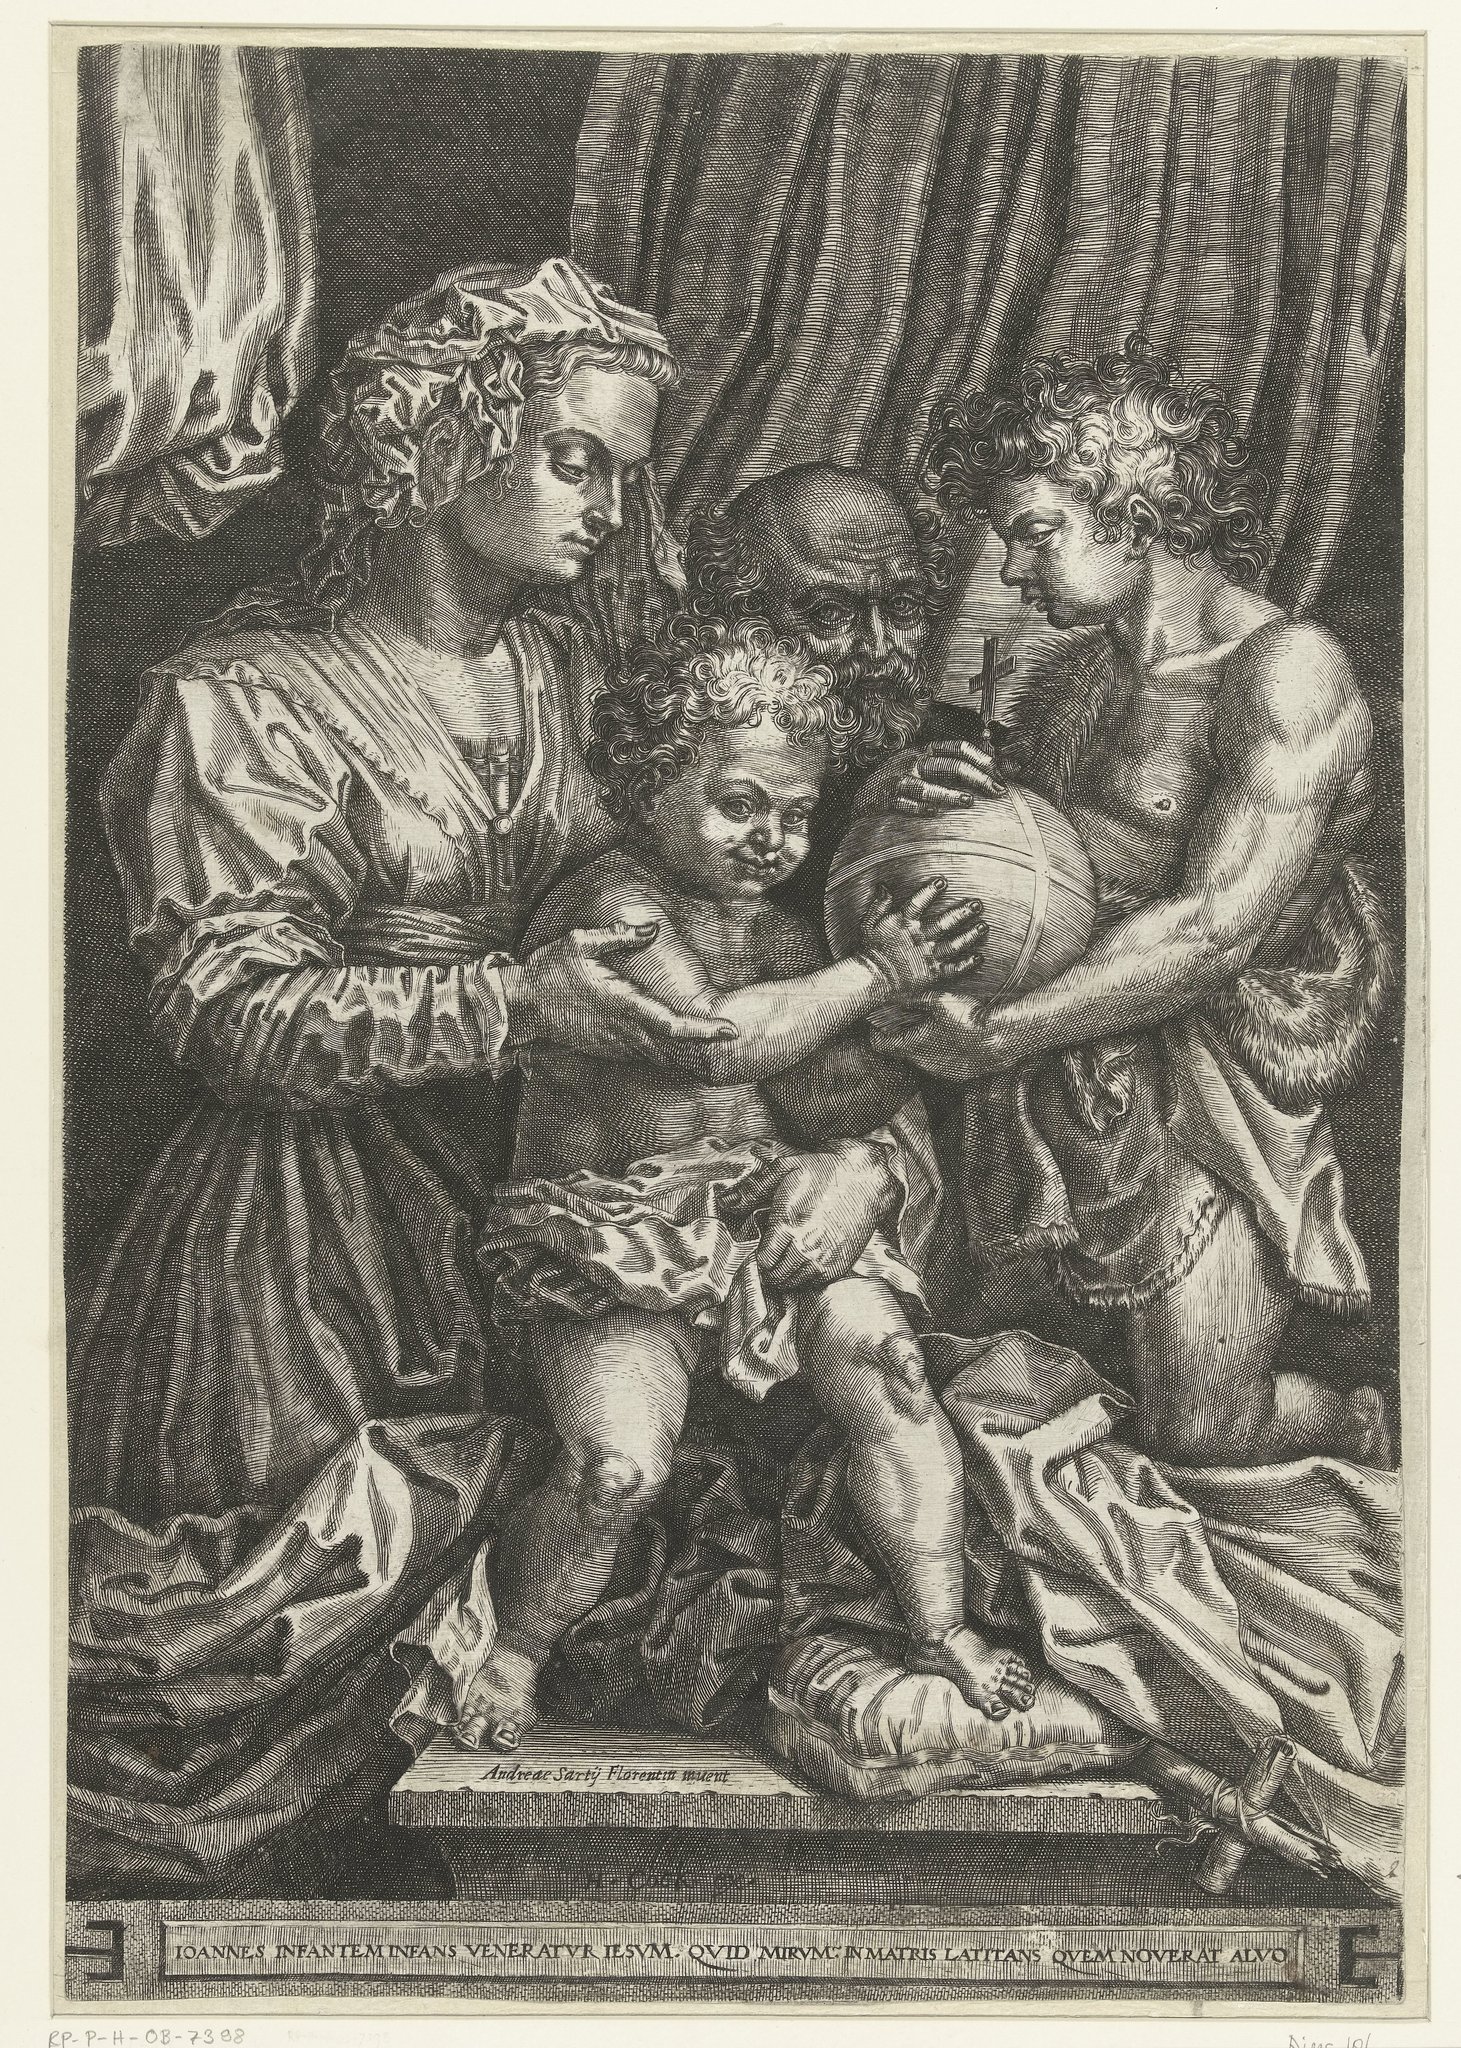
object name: print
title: Heilige Familie met Johannes de Doper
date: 1550-1570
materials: paper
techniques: engraving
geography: antwerp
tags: holy family with john the baptist (as child)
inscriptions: number: ‘2’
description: De Heilige Familie met Johannes de Doper als kind. Johannes de Doper houdt een wereldbol vast en Christus raakt de bol ook aan met zijn hand.